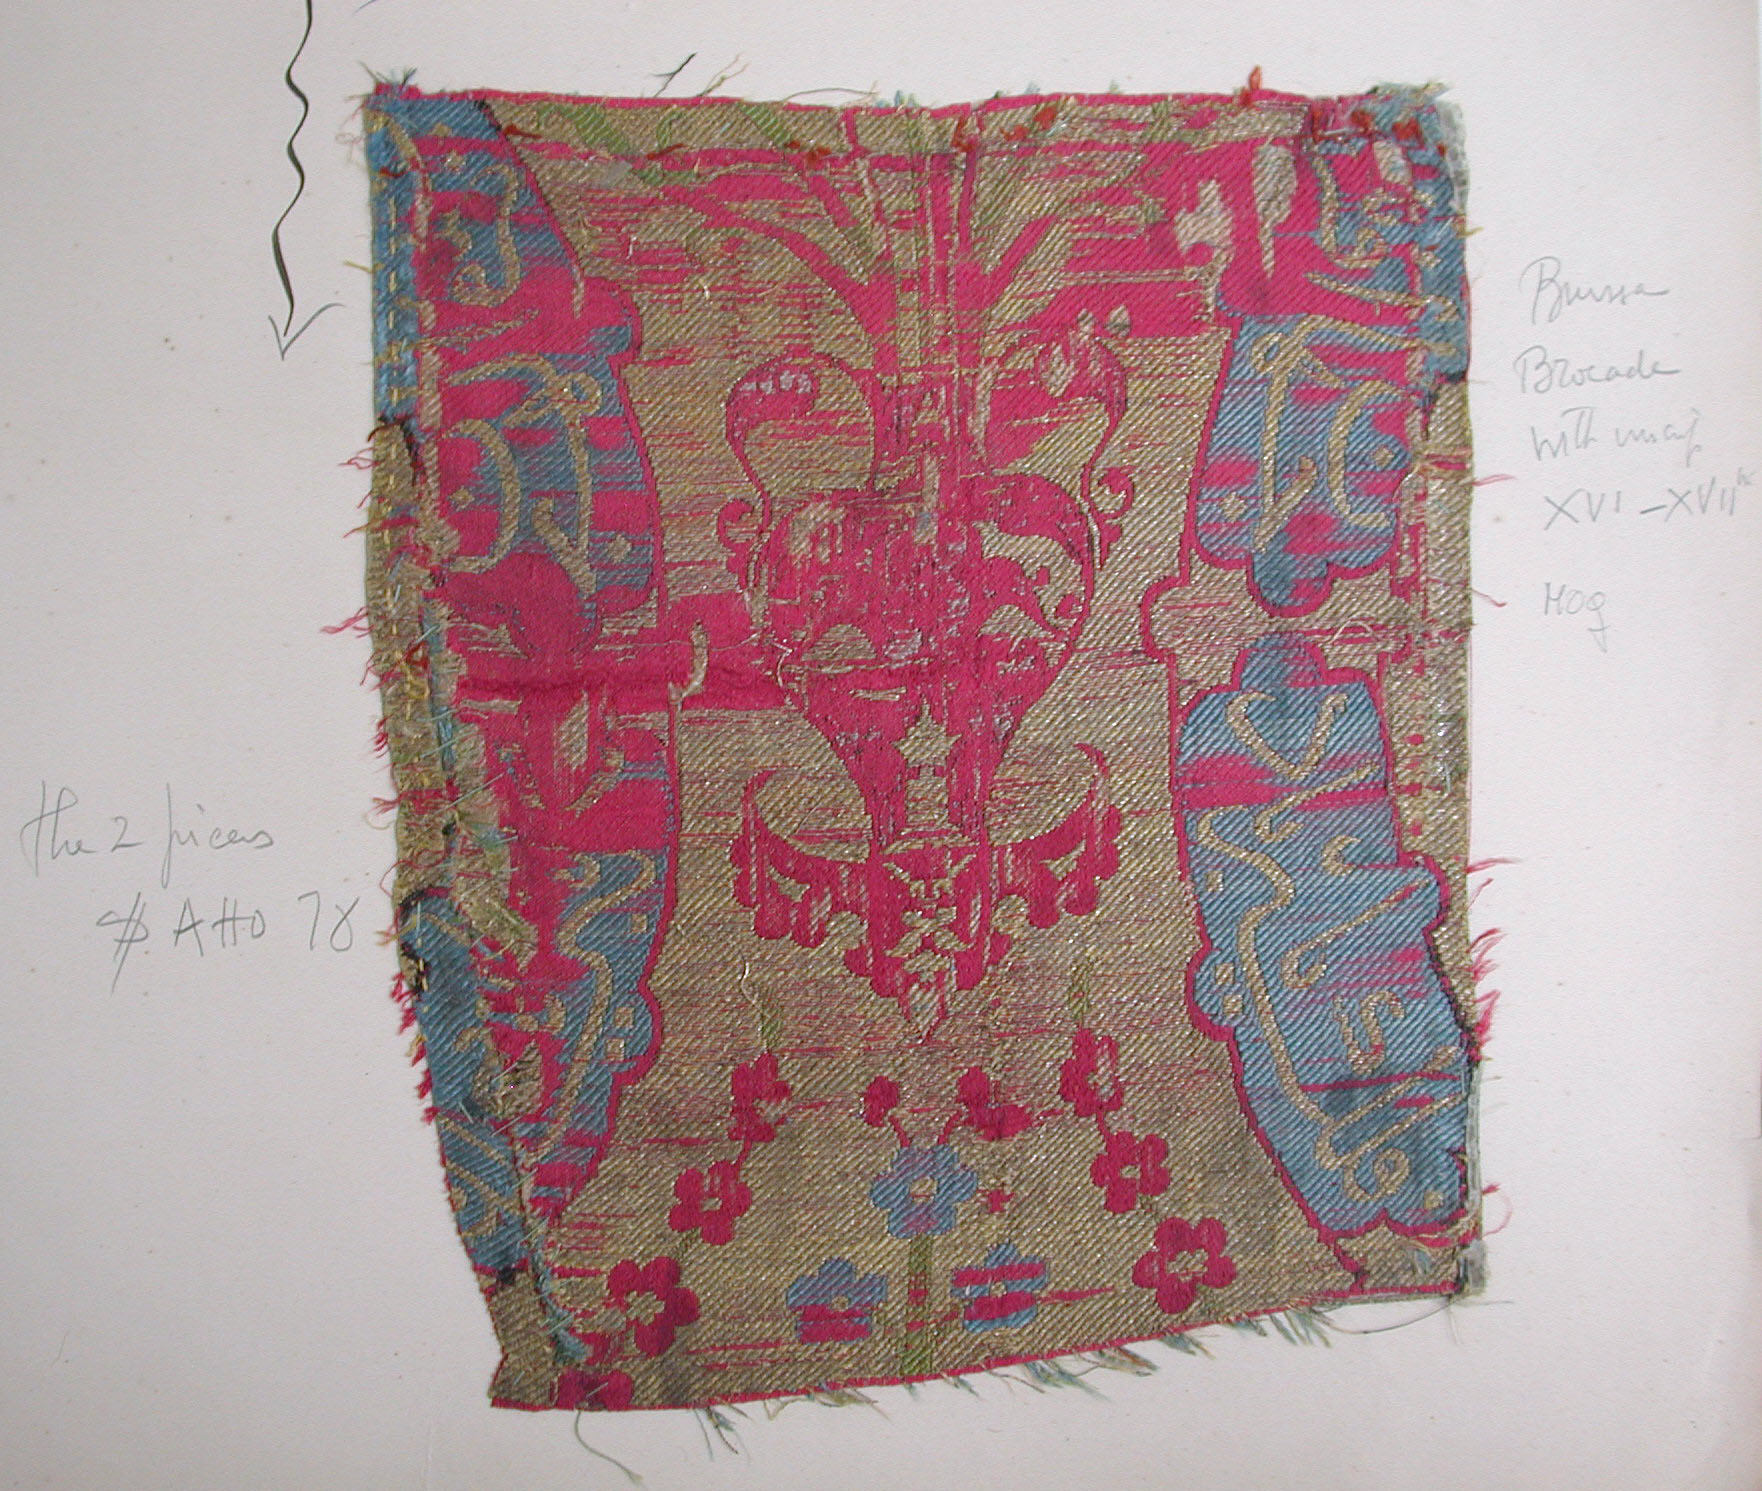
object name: textile fragment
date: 1501-1700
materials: metal thread, silk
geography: turkey